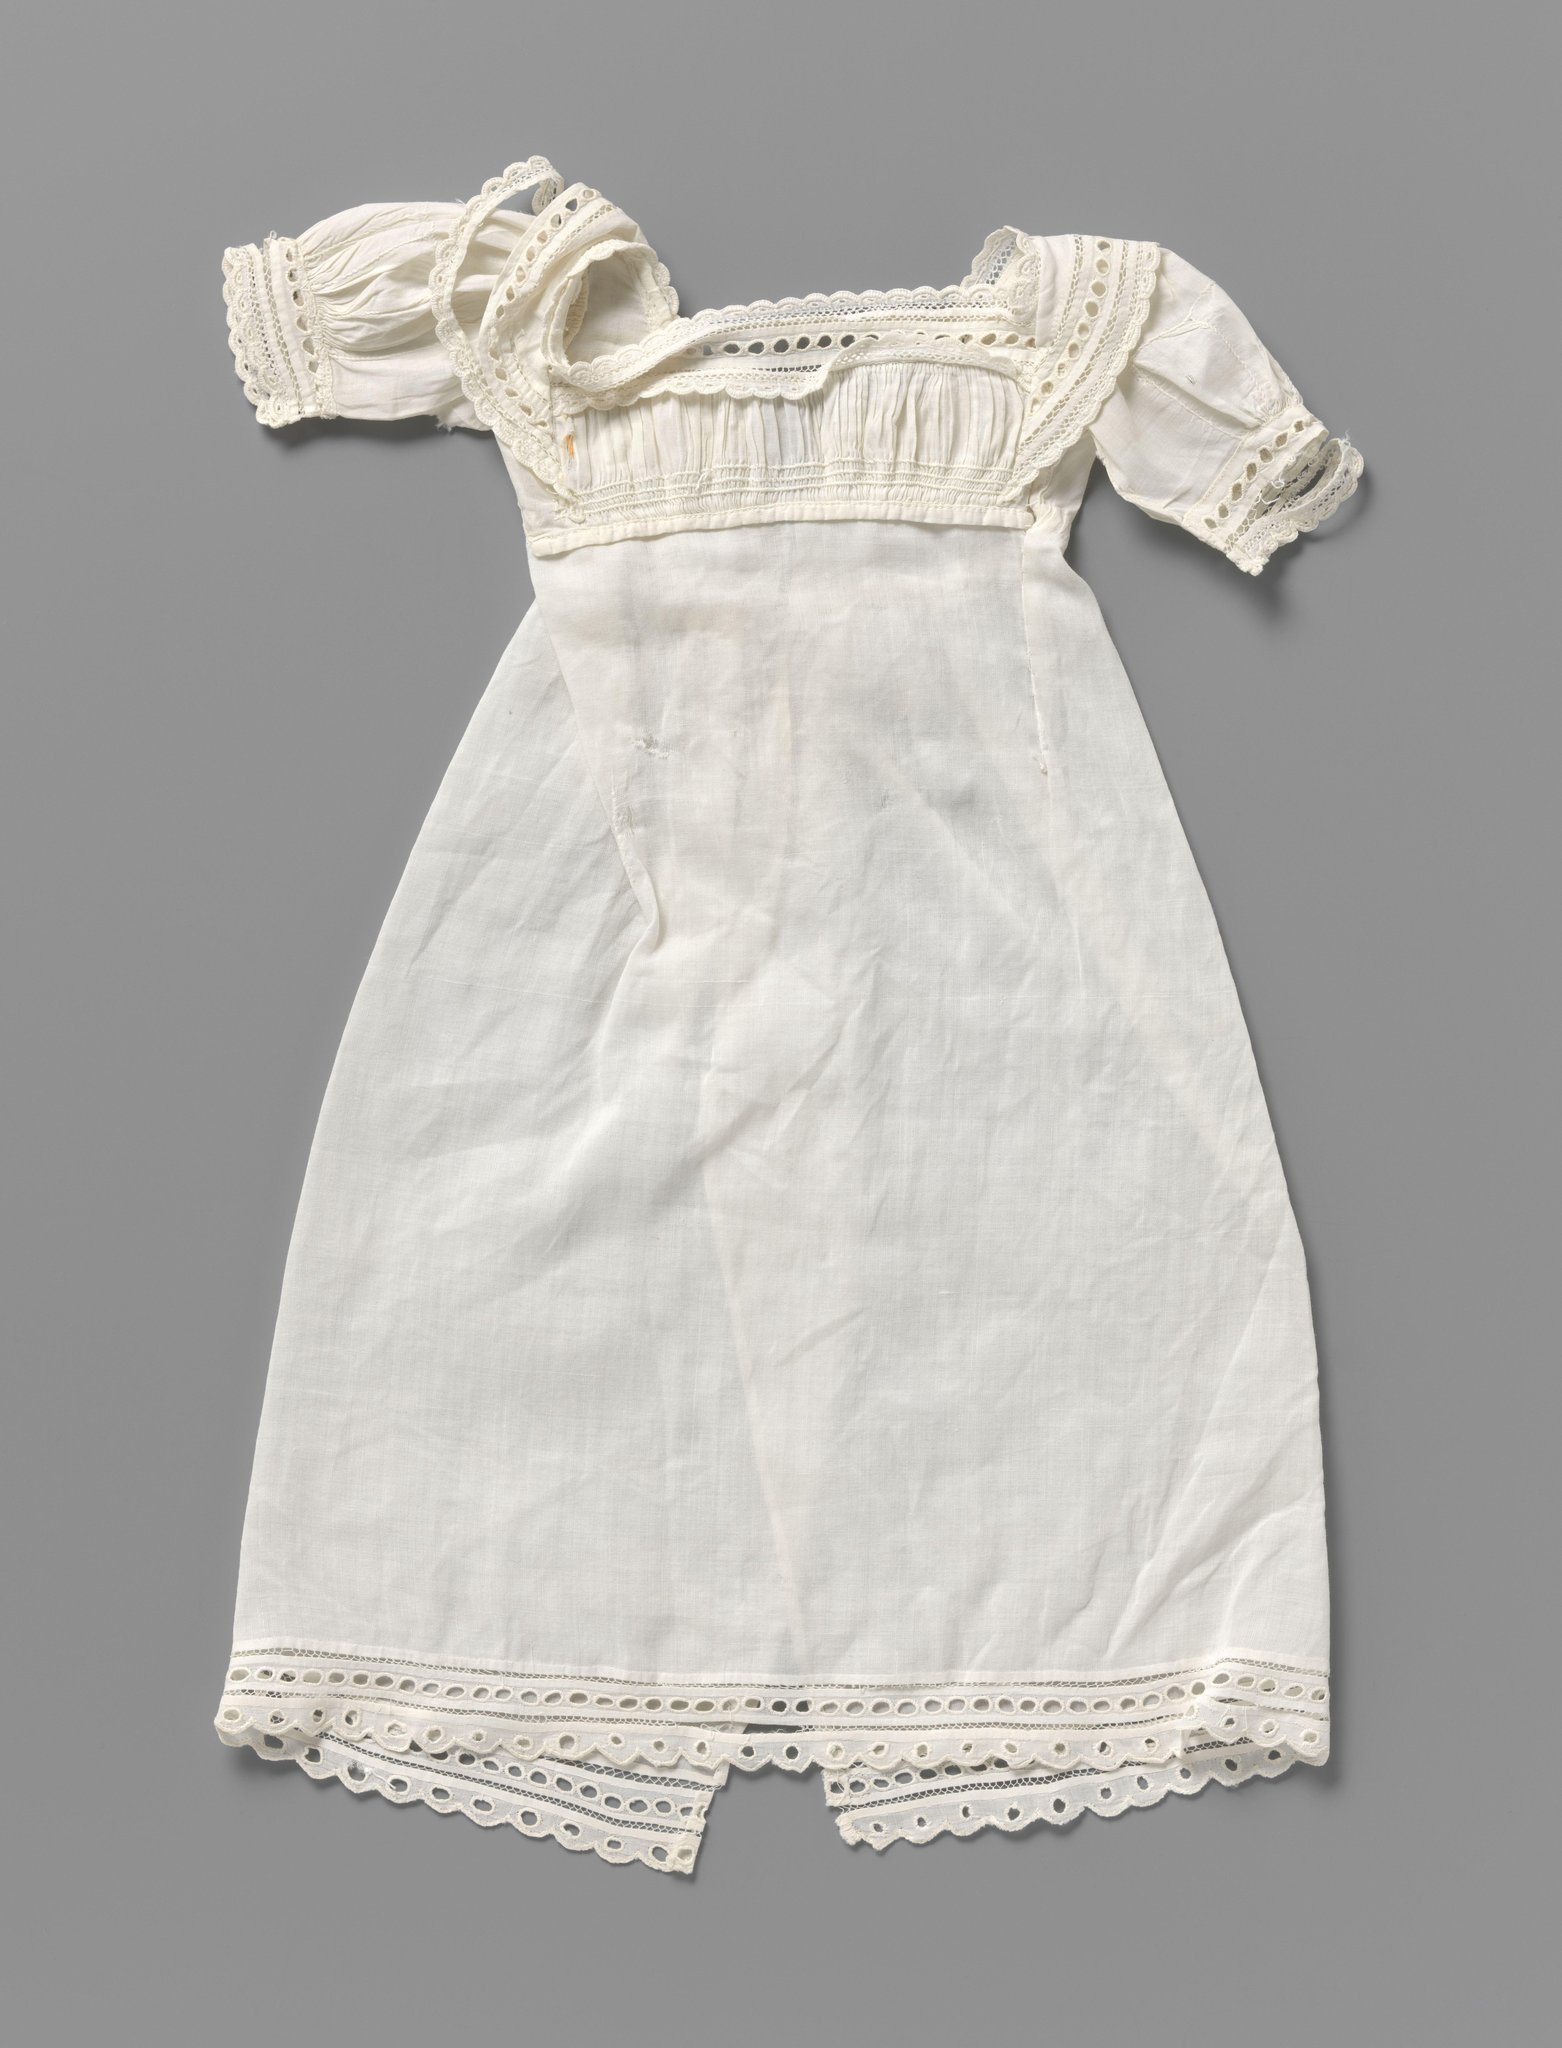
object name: robe, japon, jurk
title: Jurk, wit, voor een pop van fijn batist met boogjesgalon en oogjesranden, Empire/Restauration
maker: Anonymous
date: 1807-1812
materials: textile, cotton, linen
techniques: embroidered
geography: netherlands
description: Poppennjurkje van fijn damast met boogjesgalon en oogjesranden. Empire/Restauration. Model: Kort lijfje, van voren meermalen ingerimpeld en vanachter glad maar intrekbaar met bandje. Zeer vierkante hals met vleugelstrookje van voren, maar tot kraag doorlopend vanachter. Halve, pofmouwtjes, van onder aangerimpeld aan een strakboordje. Lange rechte rok uit één stuk; staat vanachter open. Versiering. Met een open in-en-gij-naadje zijn randen met grote gecordonneerde oogjes geborduurd, met een boogjesrand onderlangs. Deze lopen glad aangezet langs hals, vleugelkraagje, mouwtjes en de zoom. Toestand. Vele geborduurde naadjes zijn hier en daar kapot (maar zouden te herstellen zijn). In 1079 gewassen.